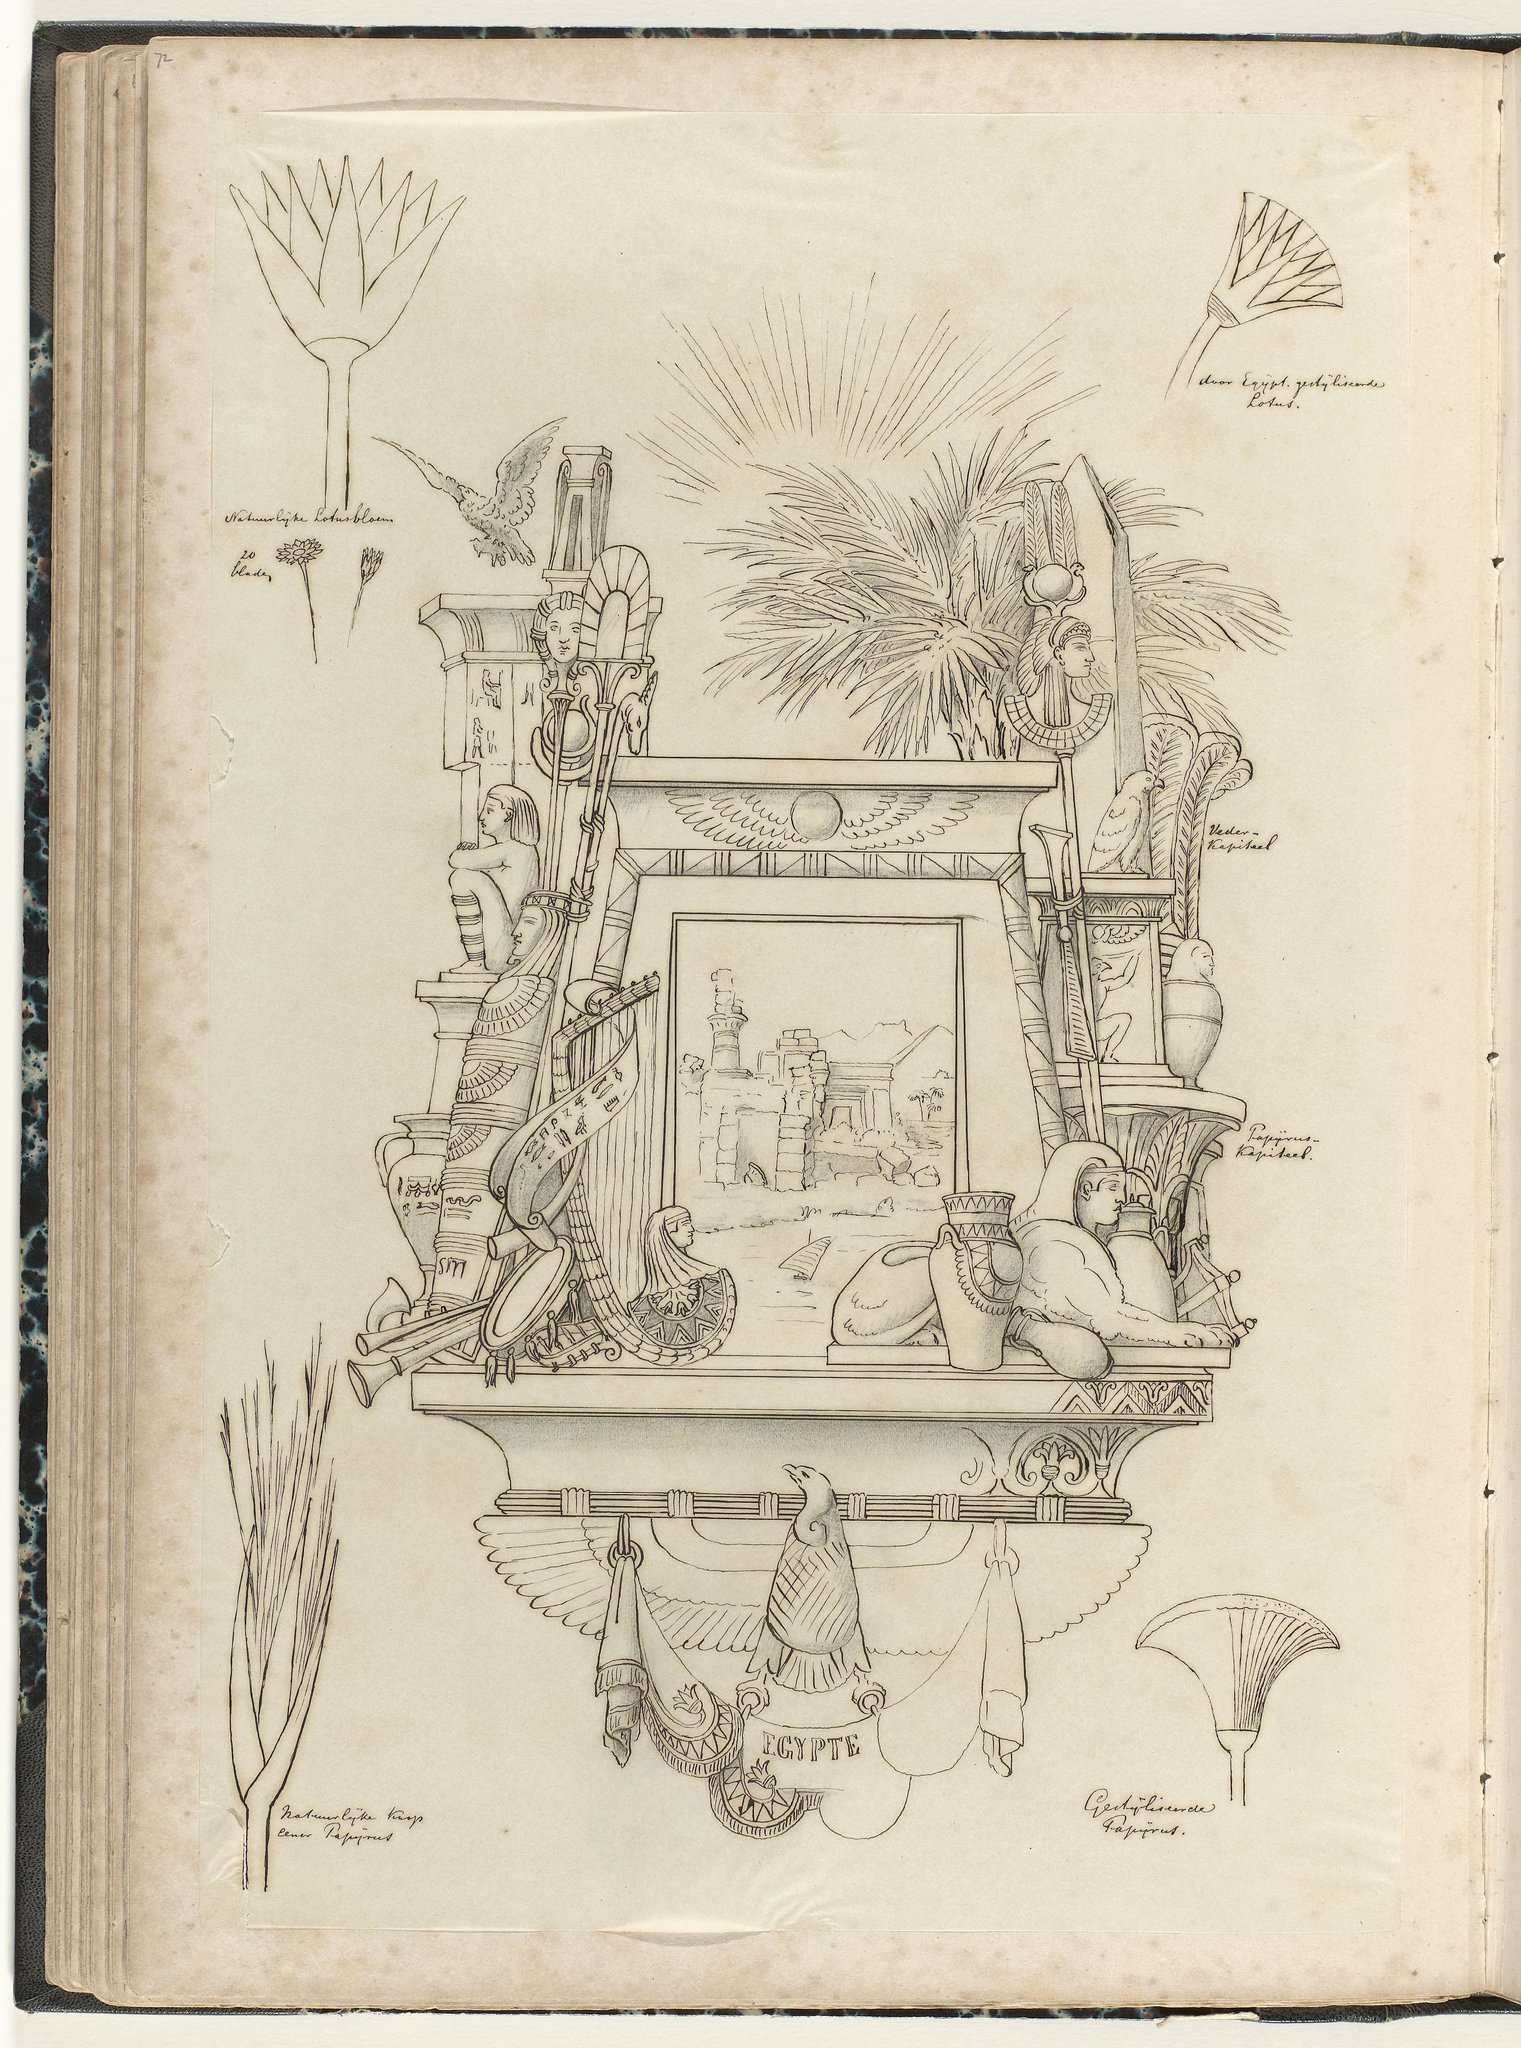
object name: drawing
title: Omlijsting met Egyptische voorwerpen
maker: Anonymous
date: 1866-1900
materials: ink, pencil, paper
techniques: drawing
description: Rondom de omlijsting zijn papyrusplanten en lotusbloemen getekend, onderaan hangt een banderol met de tekst: Egypte.